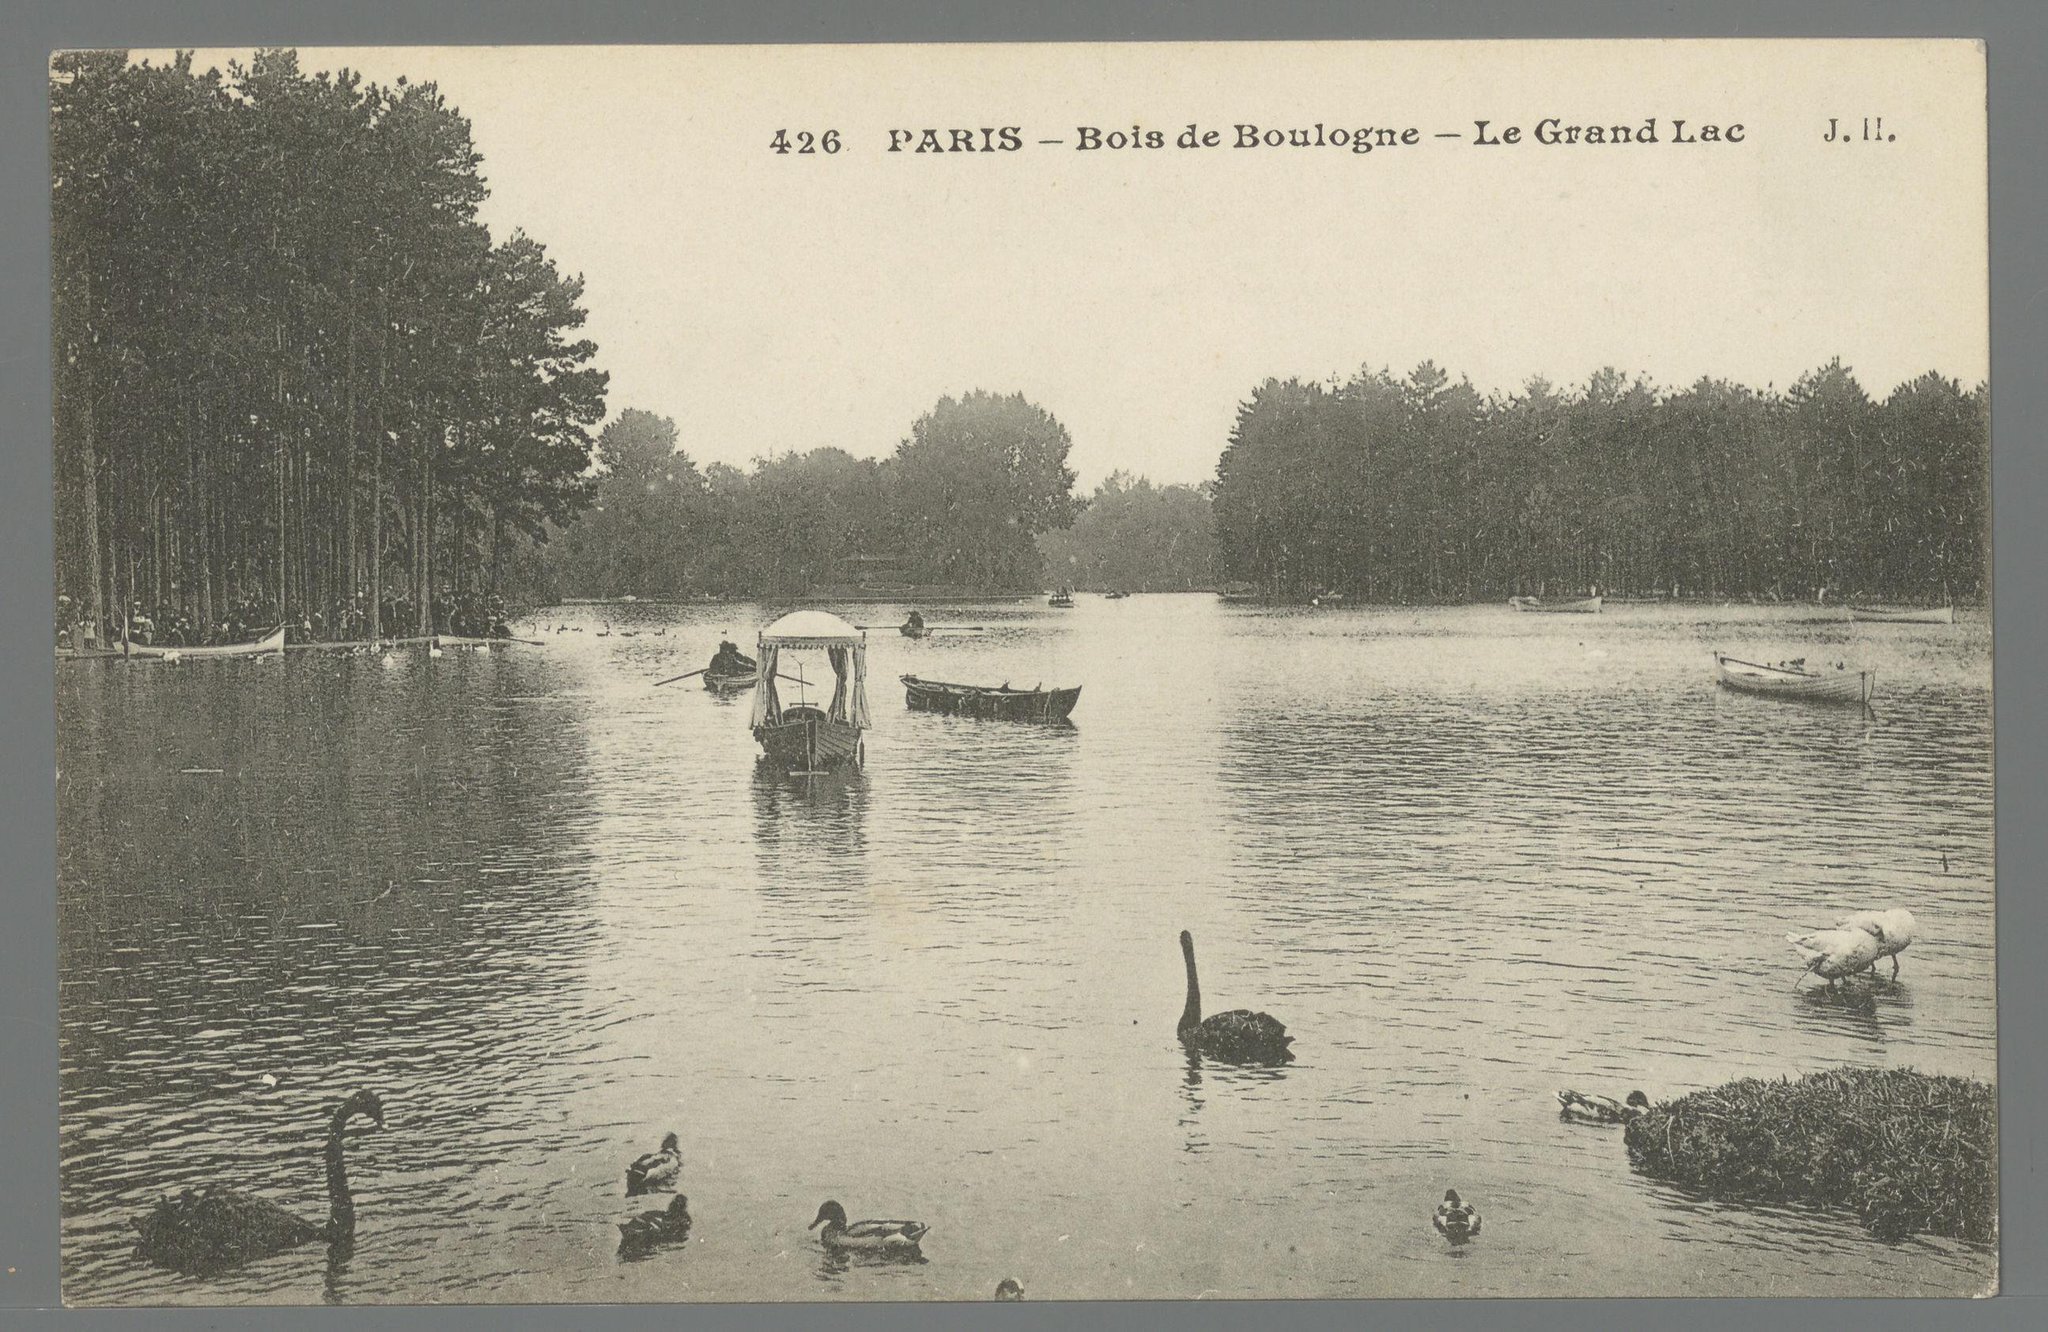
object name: ansichtkaart, prentbriefkaart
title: Paris. Bois de Boulogne. Le Grand Lac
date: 1904-1906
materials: cardboard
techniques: photograph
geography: paris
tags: public gardens, park (+ city(-scape) with figures, staffage), pool, puddle (+ landscape with figures, staffage), rowing-boat, canoe, etc.